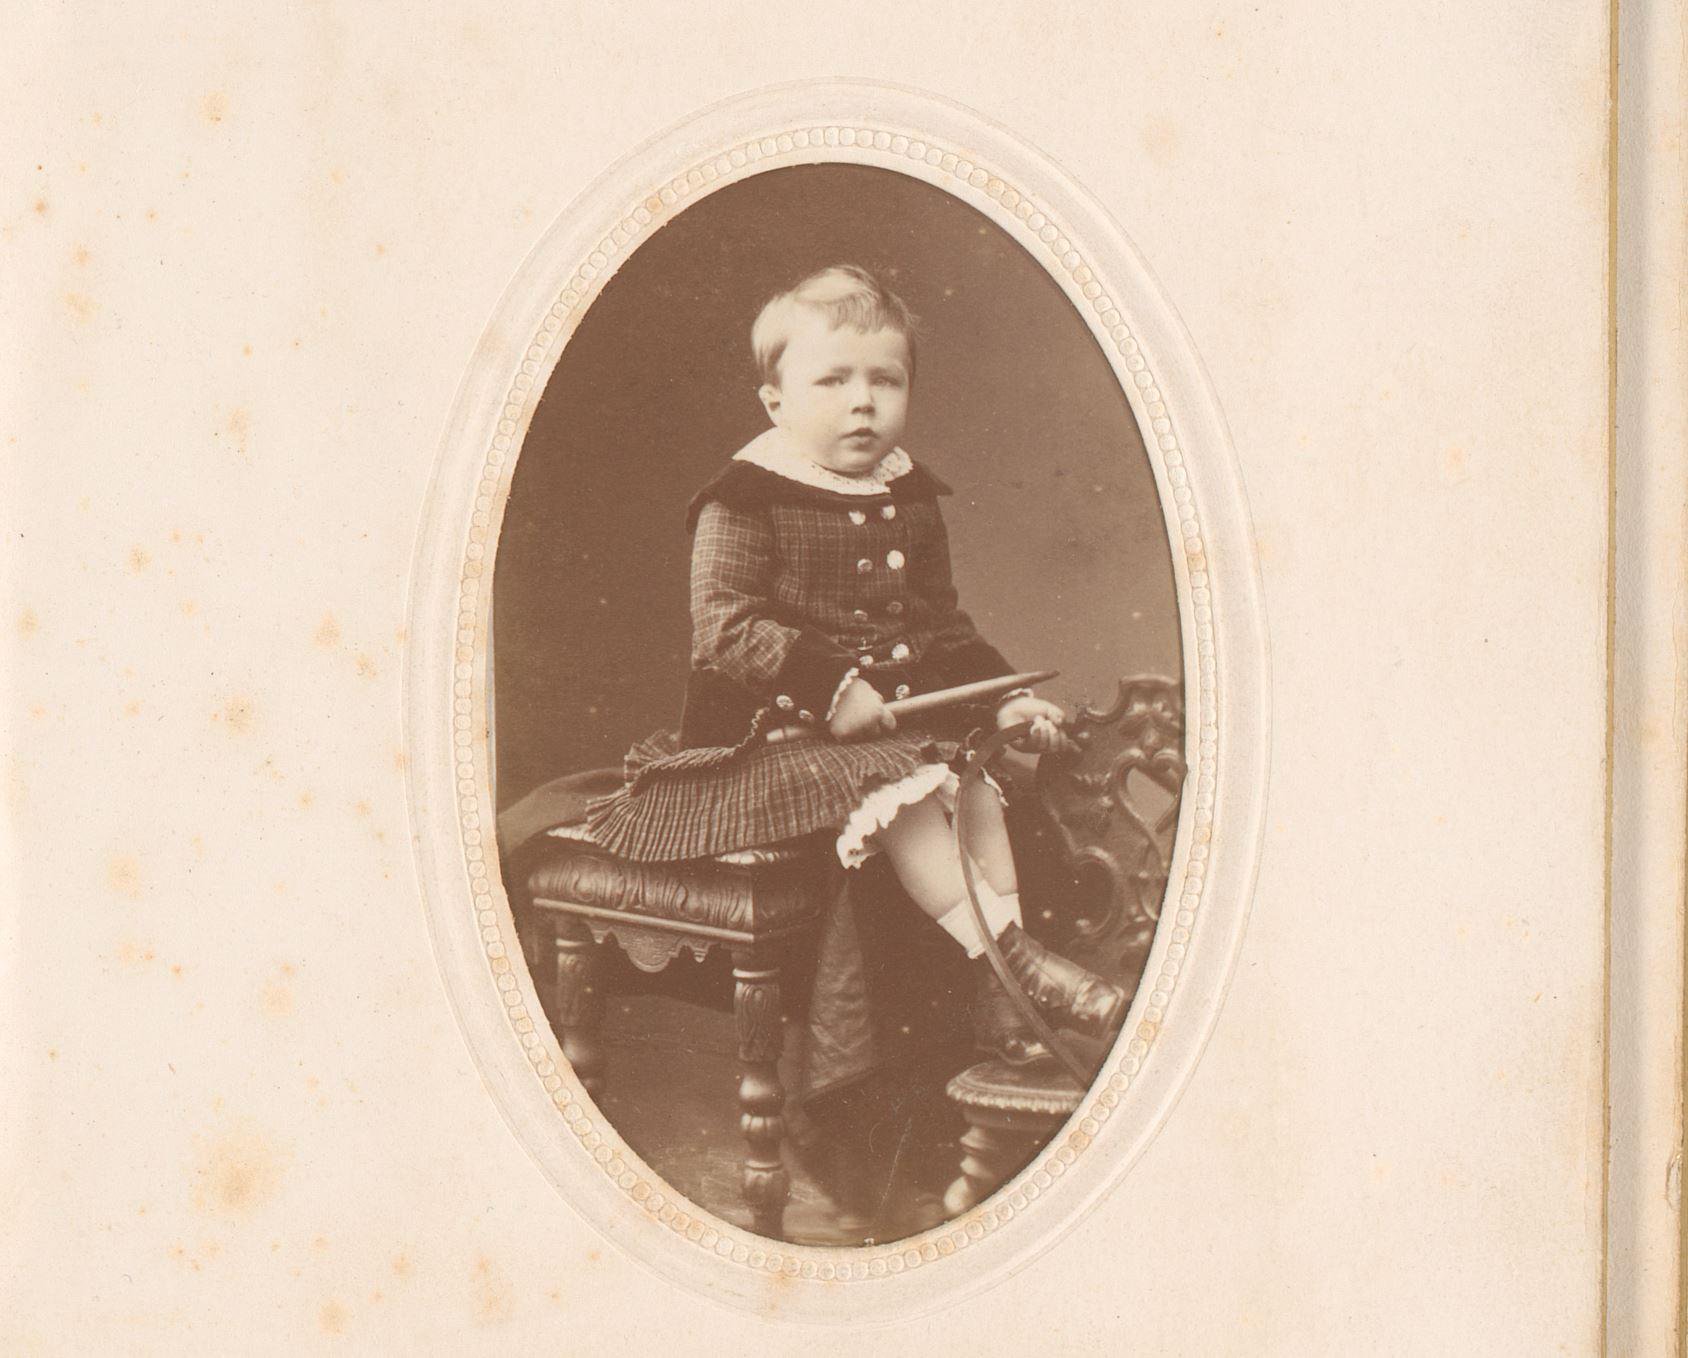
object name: album leaf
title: Portret van een jongen met hoepel in de hand, zittend op een taboeret, aangeduid als Jules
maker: michel berthaud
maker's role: publisher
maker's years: 1845-1912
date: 1898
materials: cardboard, photographic support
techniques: albumen print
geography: paris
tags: sitting figure, historical persons, toddler (male), (bowling a) hoop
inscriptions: inscription: ‘M. BERTHAUD/ 9, Rue Cadet, 9/ Paris/ SUCCURSALES À/ BOULOGNE S/MER/ ABBEVILLE/ CHARTRES/ DREUX/ MEAUX/ Tous les clichés sont conservés.’, annotation: ‘Jules agé 2 ans 8 mois/ 1898’